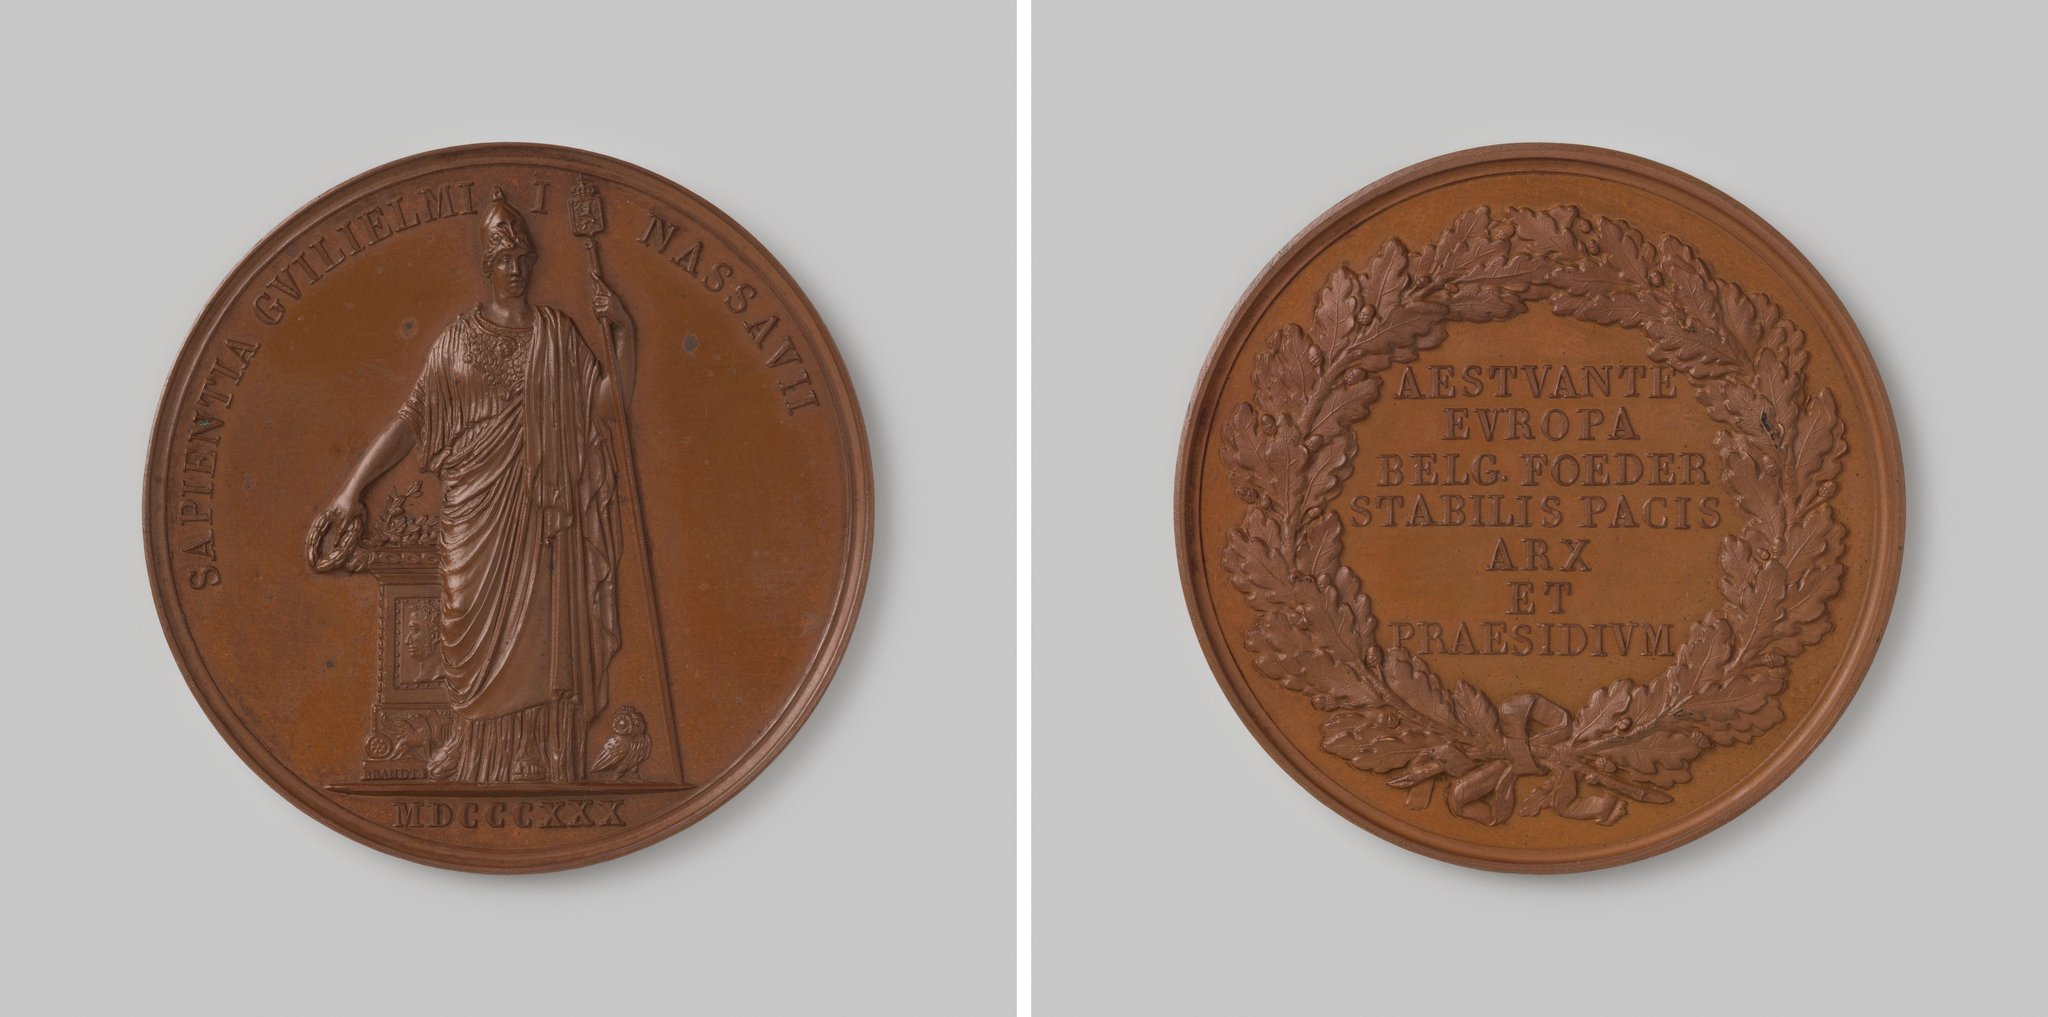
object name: history medal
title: Op de wijsheid van Koning Willem I 1830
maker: brandt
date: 1830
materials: bronze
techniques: striking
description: Bronzen penning, op de voorzijde Minerva staand bij een altaar waarop de afbeelding van Willem I, met omschrift en afsnedetekst, op de keerzijde zeven regels tekst tussen samengestrikte eikentakken.